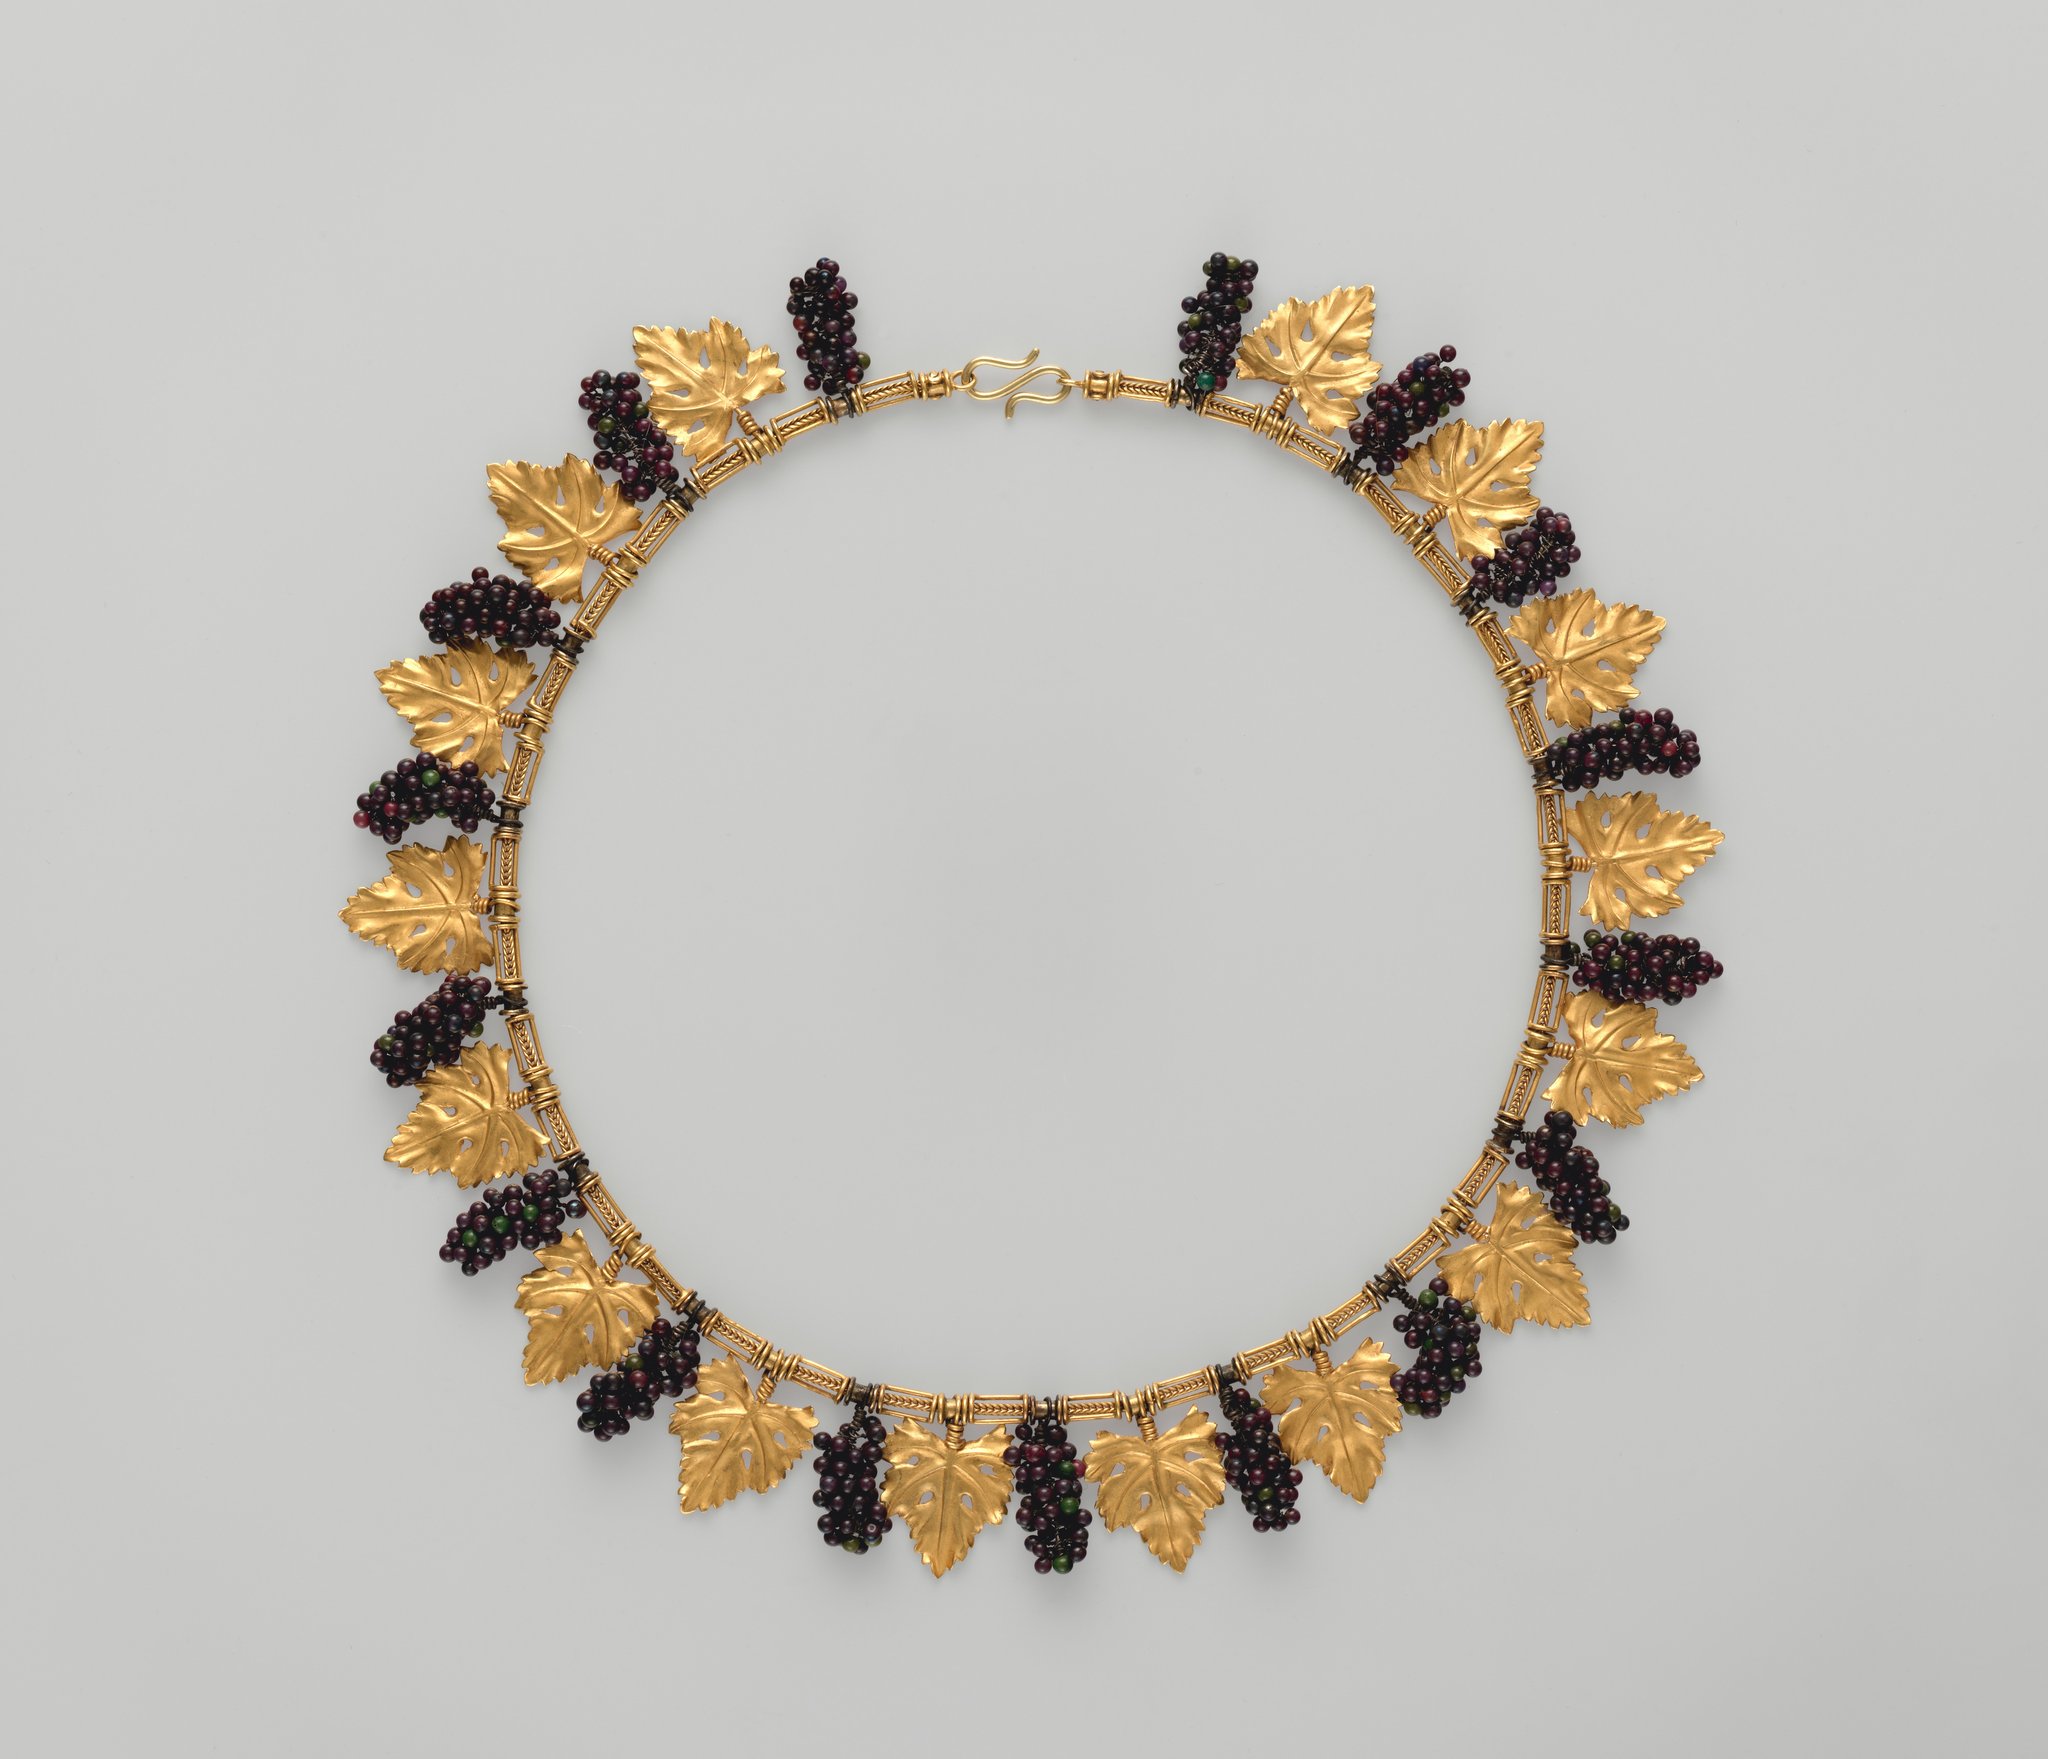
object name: necklace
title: Archaeological revival necklace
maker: castellani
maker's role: maker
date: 1880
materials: glass, gold